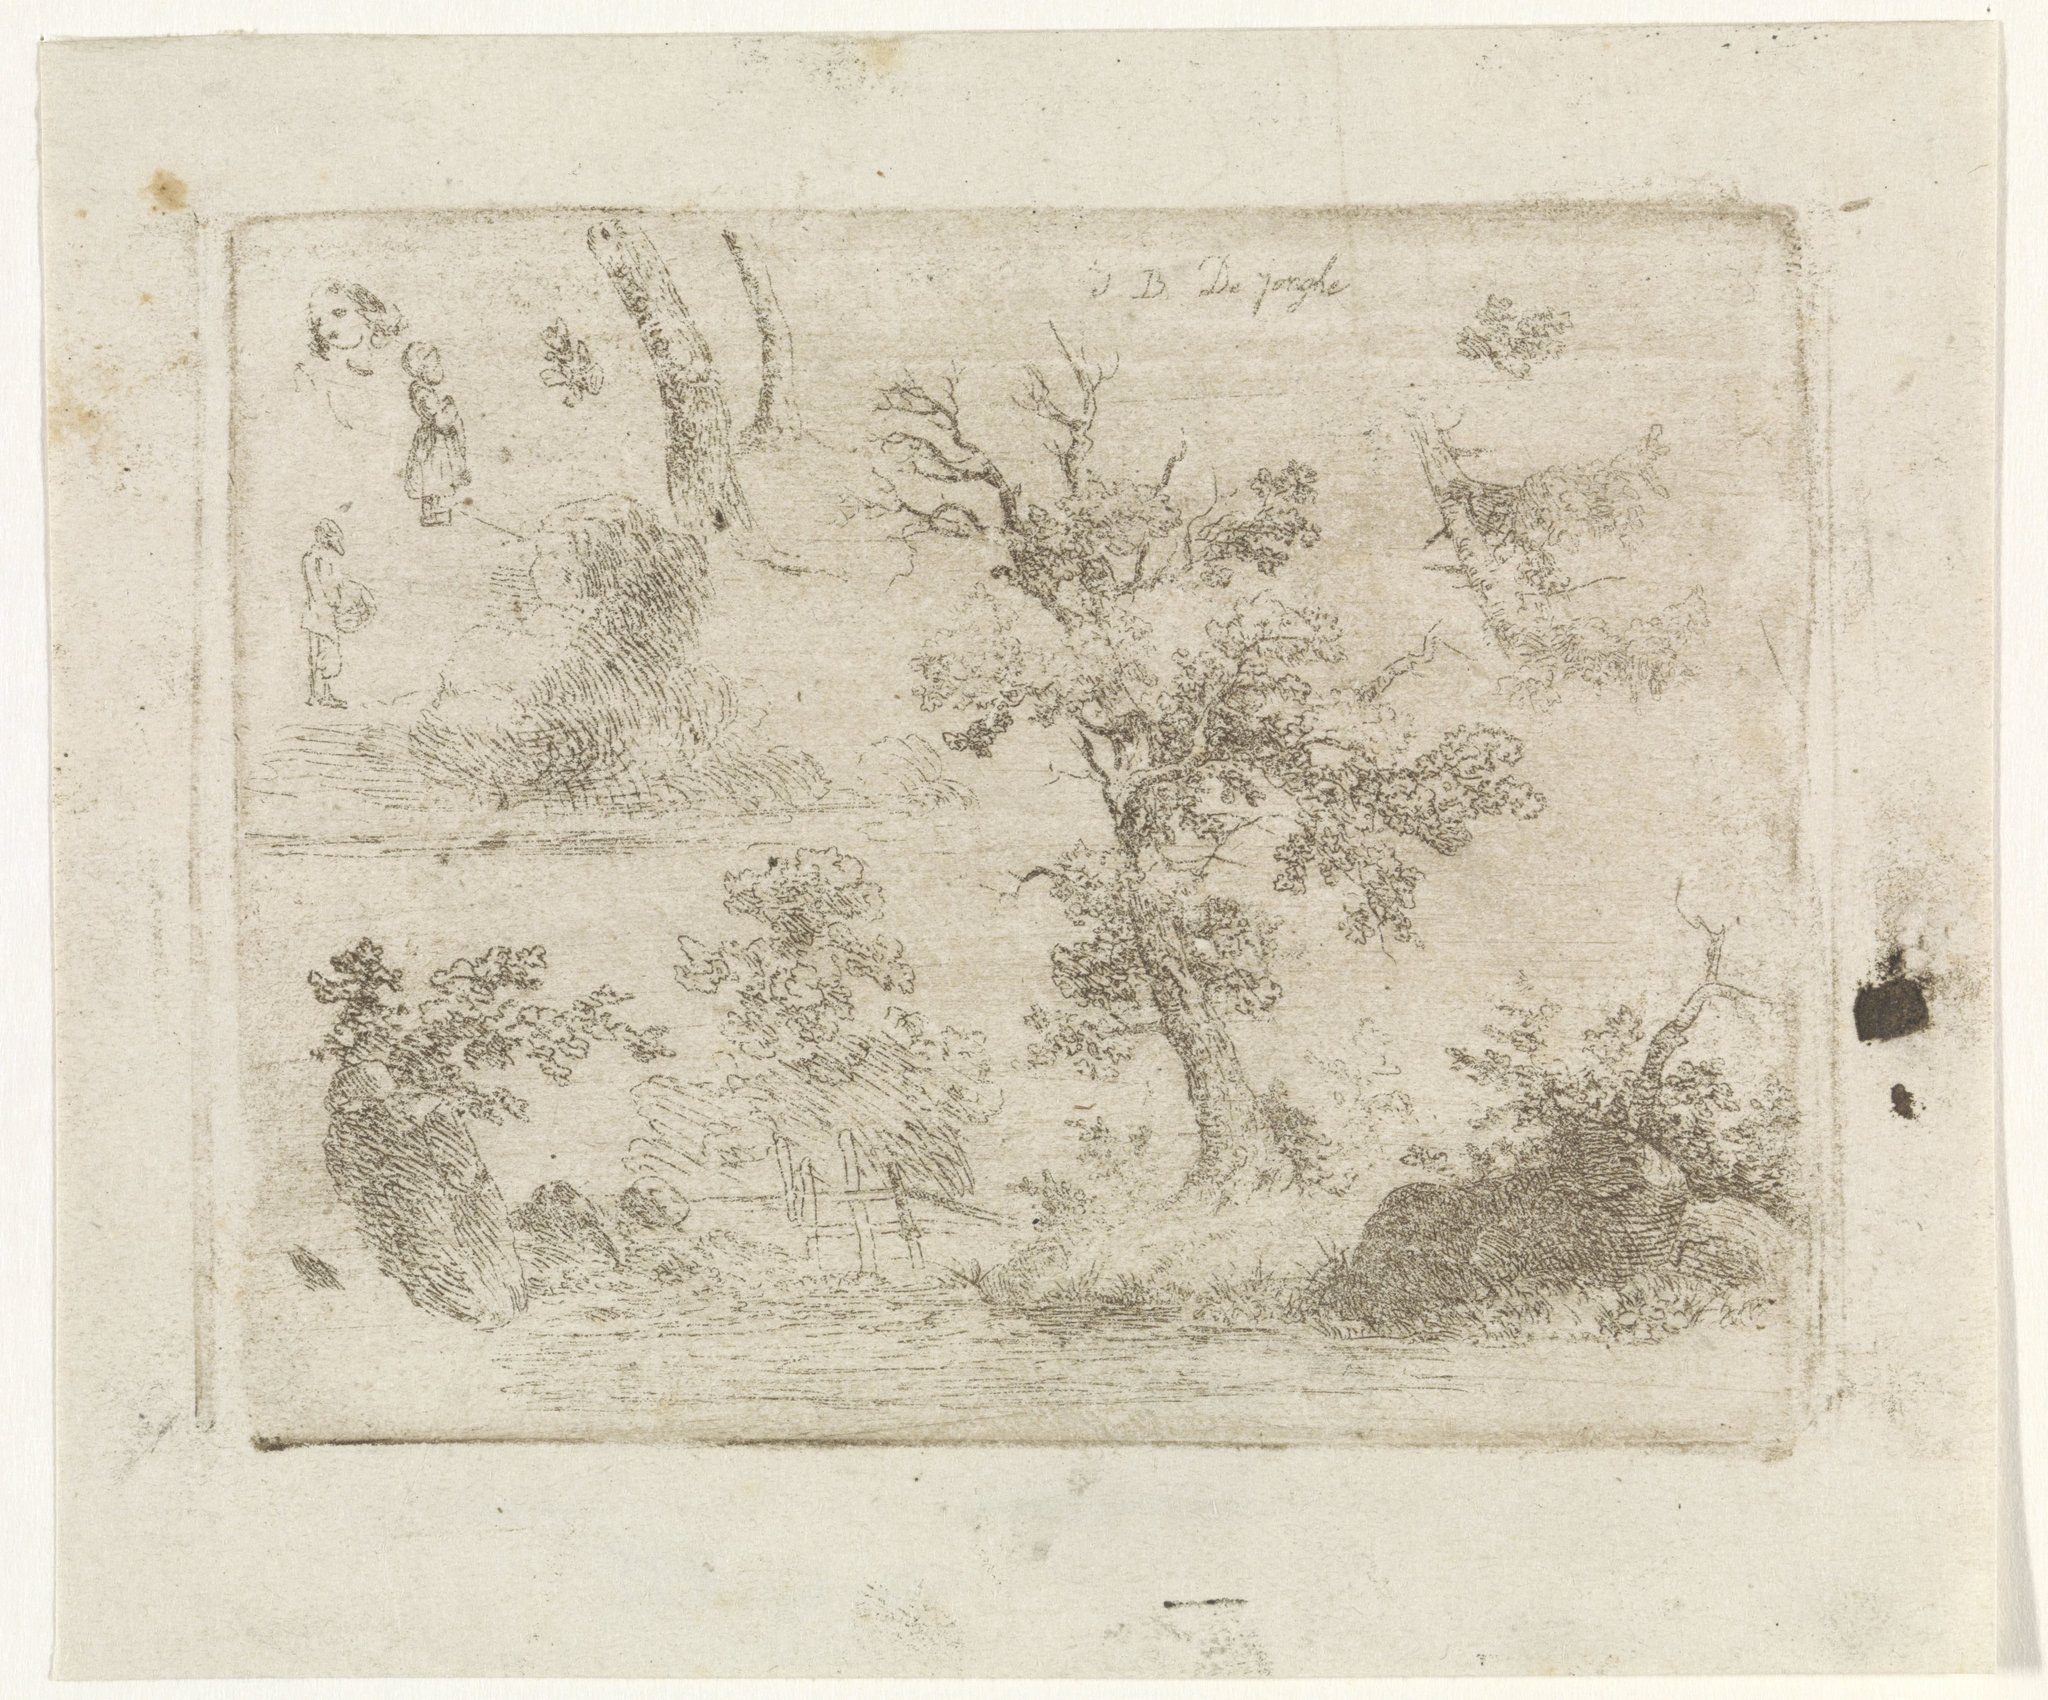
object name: print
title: Landschap en figuurstudies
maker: jan baptiste de jonghe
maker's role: painter, print maker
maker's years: 1785-1844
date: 1800-1844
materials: paper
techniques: etching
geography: belgium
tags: landscapes (+ landscape with figures, staffage)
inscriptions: inscription, collector's mark: Lugt 2228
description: Bosrijk landschap met rivier en linksboven enkele figuurstudies.